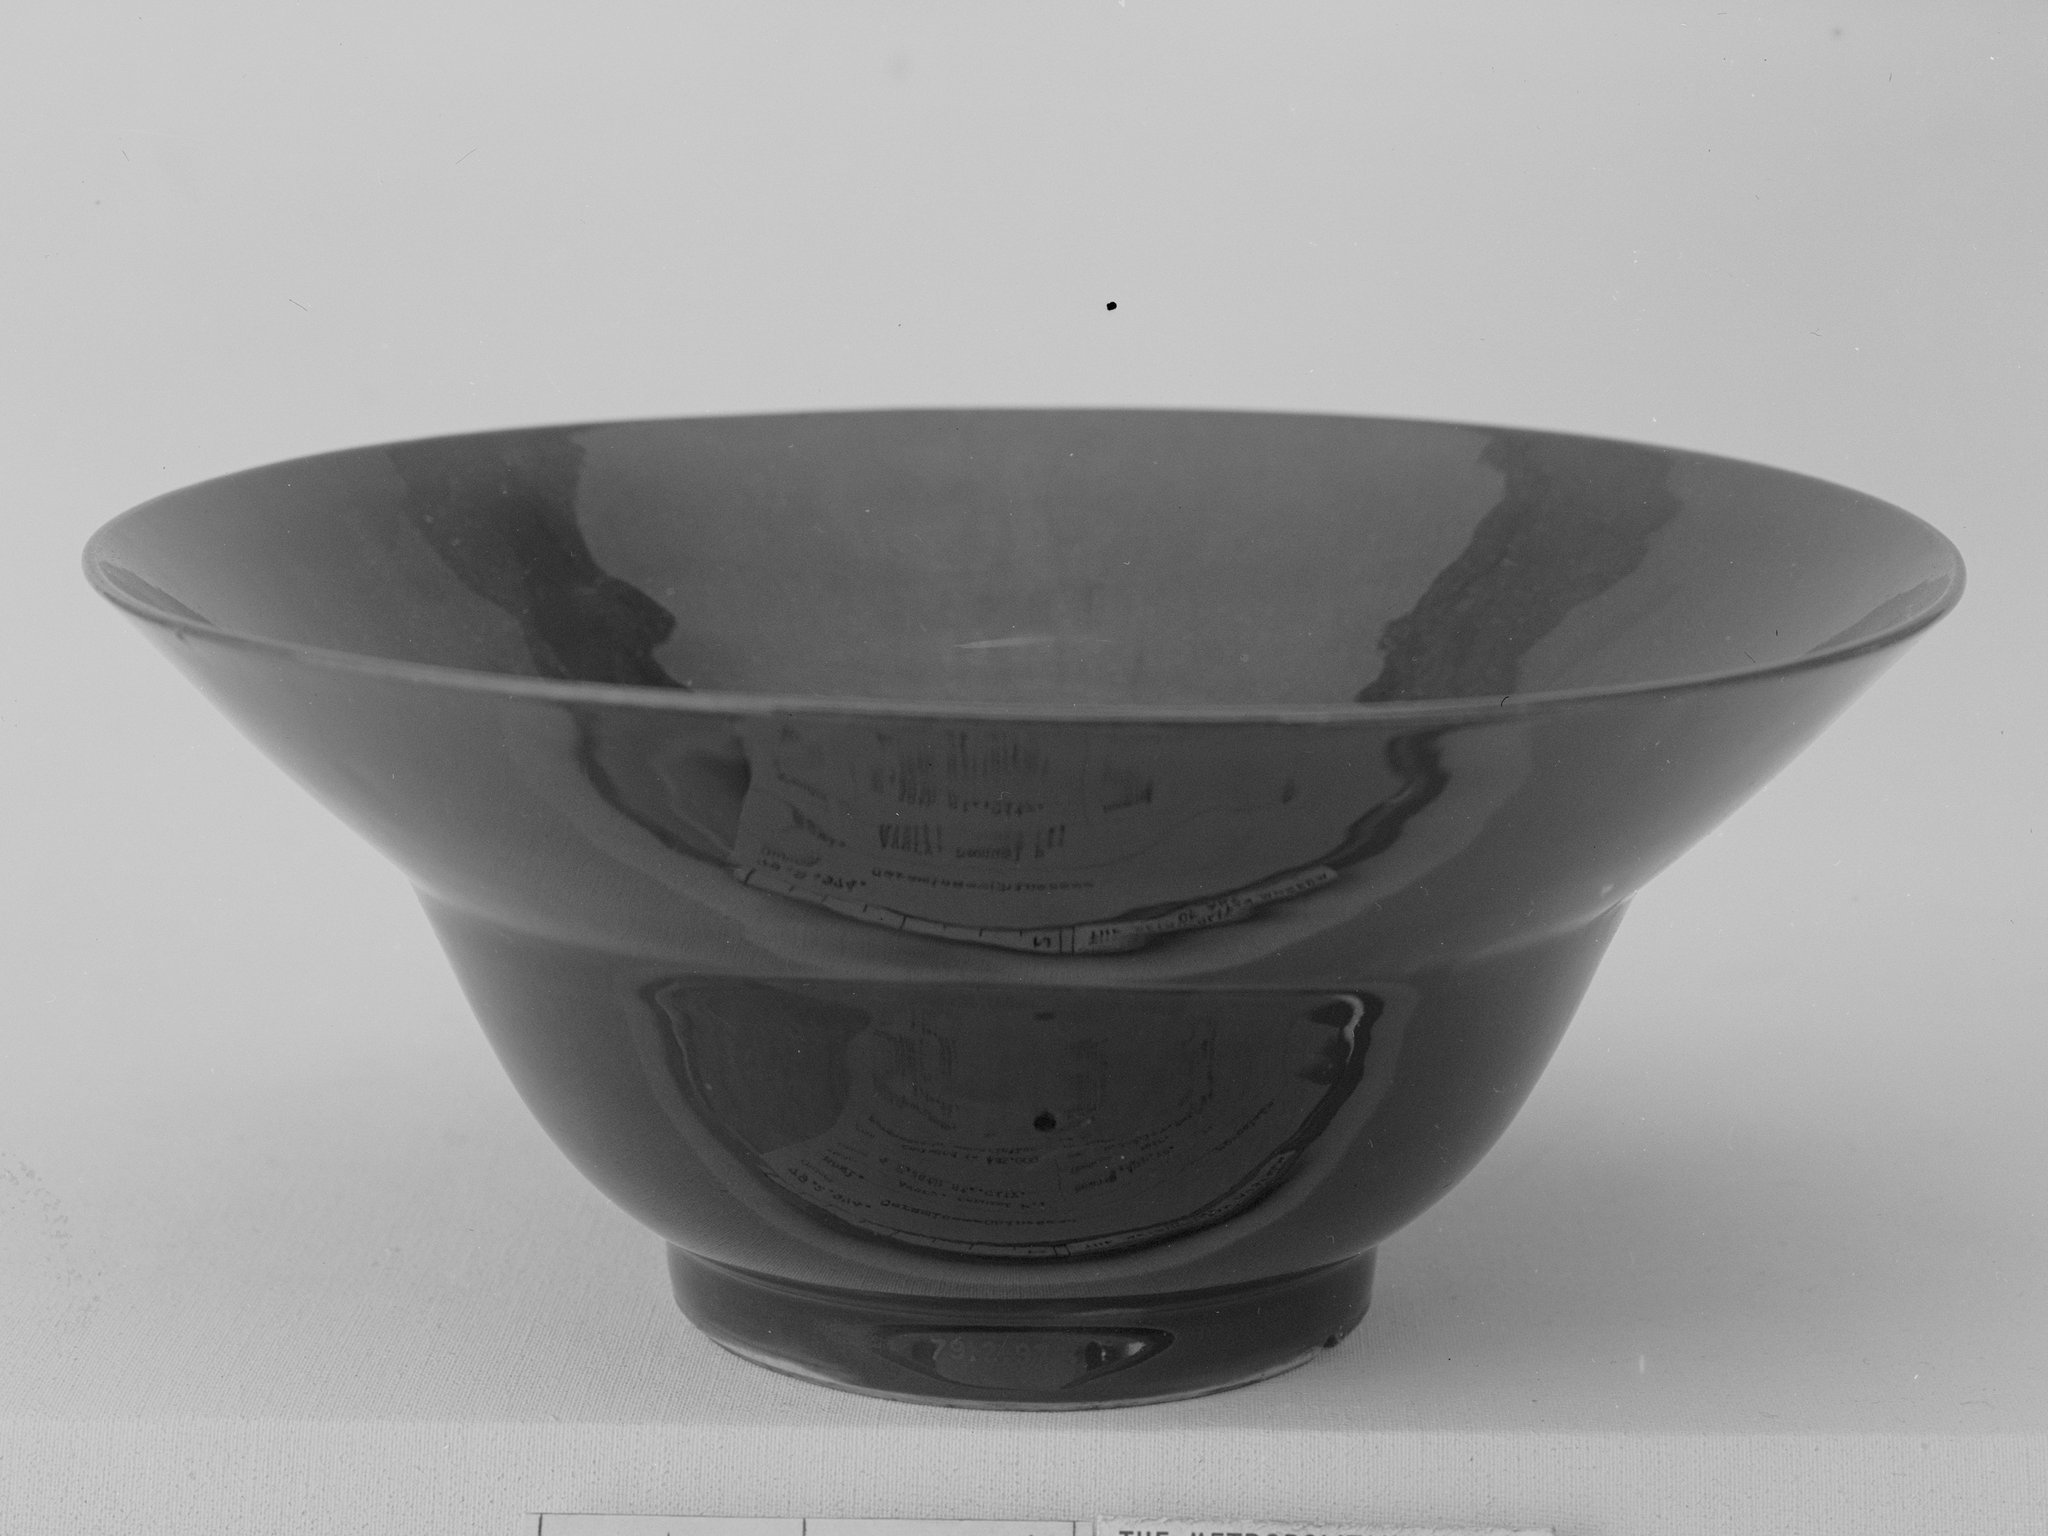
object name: bowl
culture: chinese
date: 1701-1800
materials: glaze, porcelain